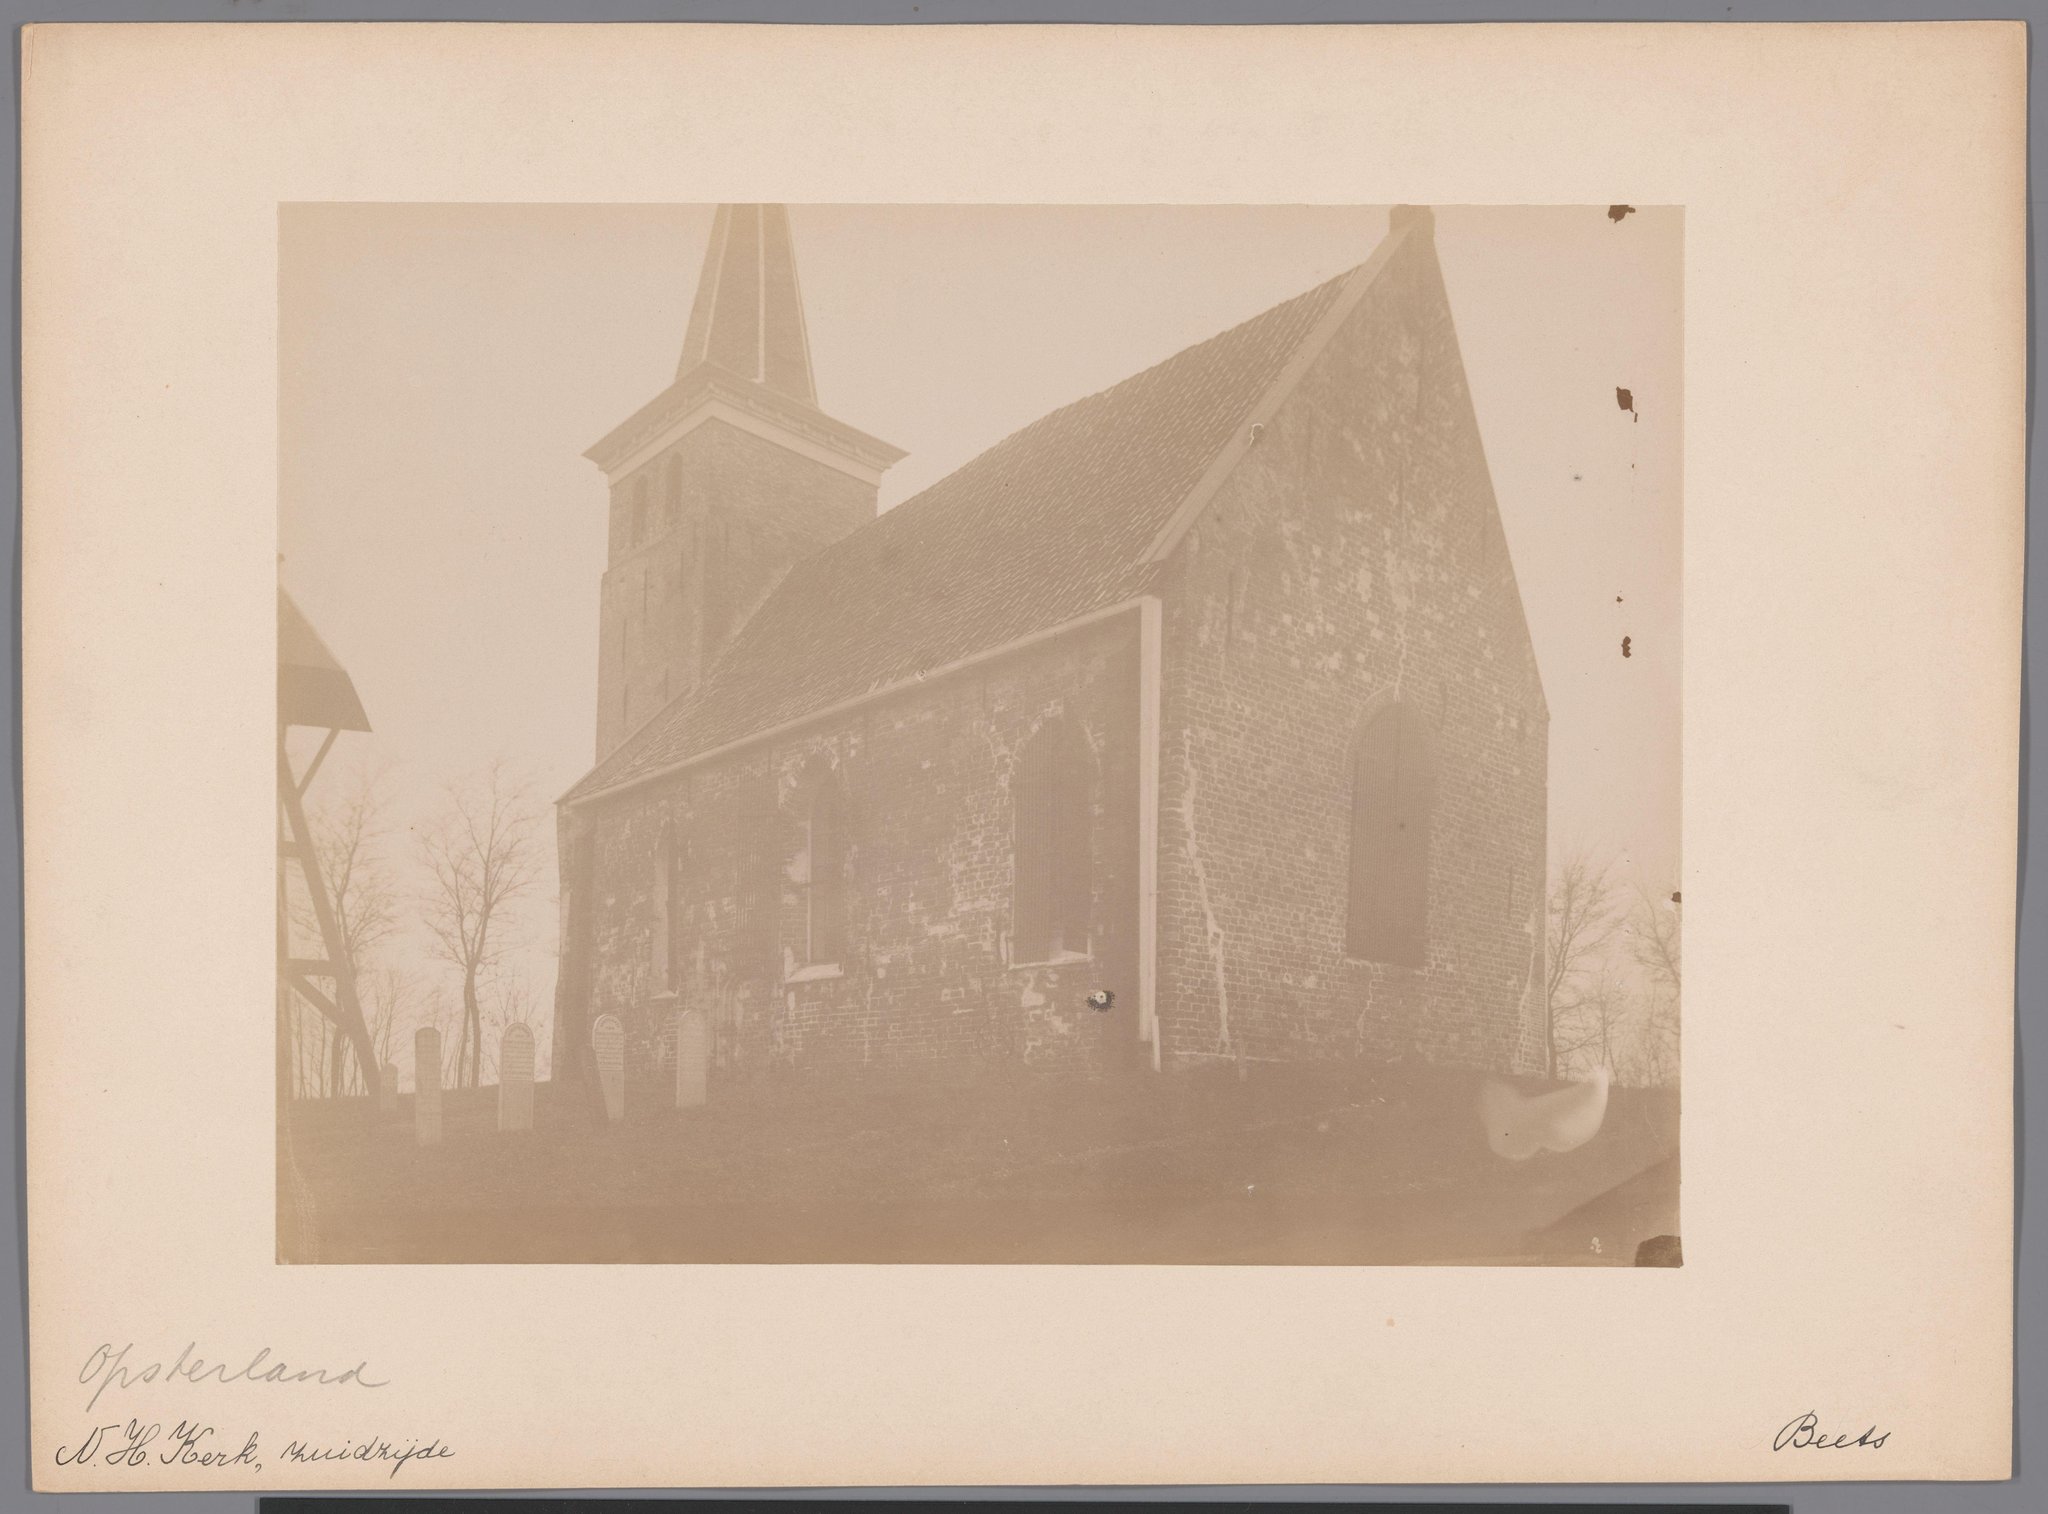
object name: photograph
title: Zuidzijde van de Gertrudiskerk te Beets, afgebroken in 1890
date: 1880-1890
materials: cardboard, photographic support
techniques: albumen print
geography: beets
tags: church (exterior)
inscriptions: annotation: ‘N.H. Kerk te Beets / Zuidzijde’, annotation: ‘Opsterland/ N.H. Kerk, zuidzijde/ Beets’